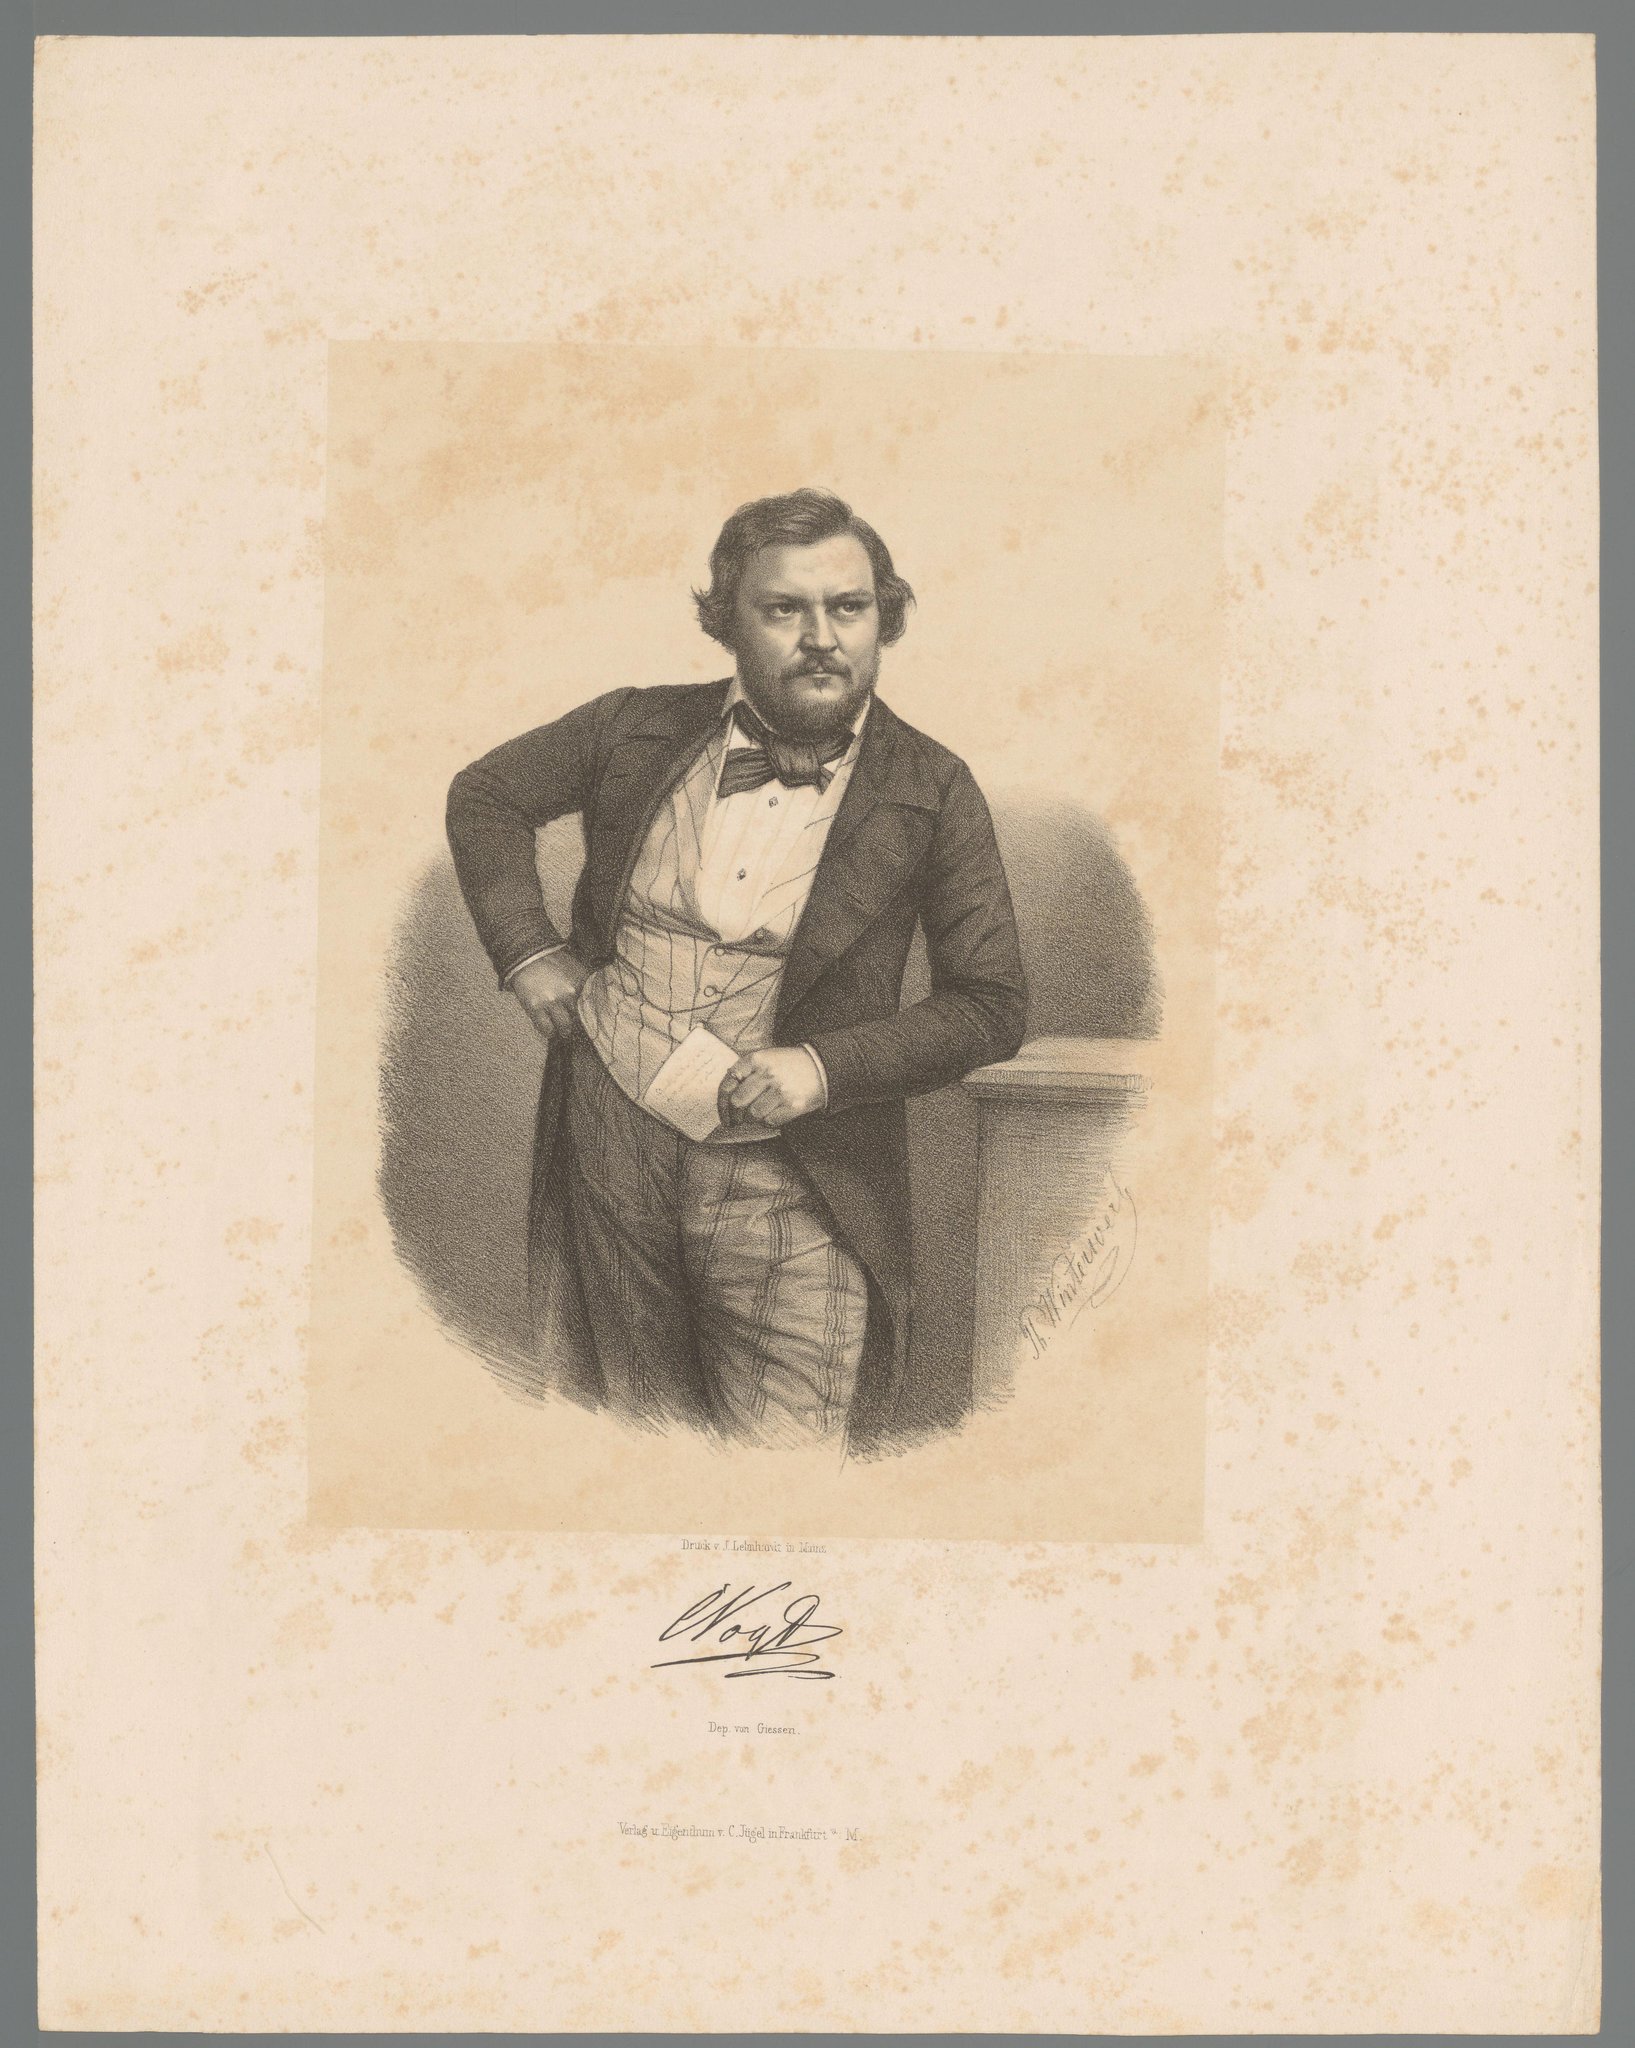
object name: print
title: Portret van Carl Vogt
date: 1849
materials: paper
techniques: tone lithography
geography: mainz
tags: adult man, historical persons, beard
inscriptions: collector's mark: Lugt 2228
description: Prent behoort waarschijnlijk tot de serie 'Album der deutschen National-Versammlung'. Deze serie bestaat uit circa 54 portretten die onder andere zijn vervaardigd door Philipp Winterwerb en Heinrich Hasselhorst naar foto's van Seib. Deze serie is in 1849 uitgegeven door Carl Christian Jügel.